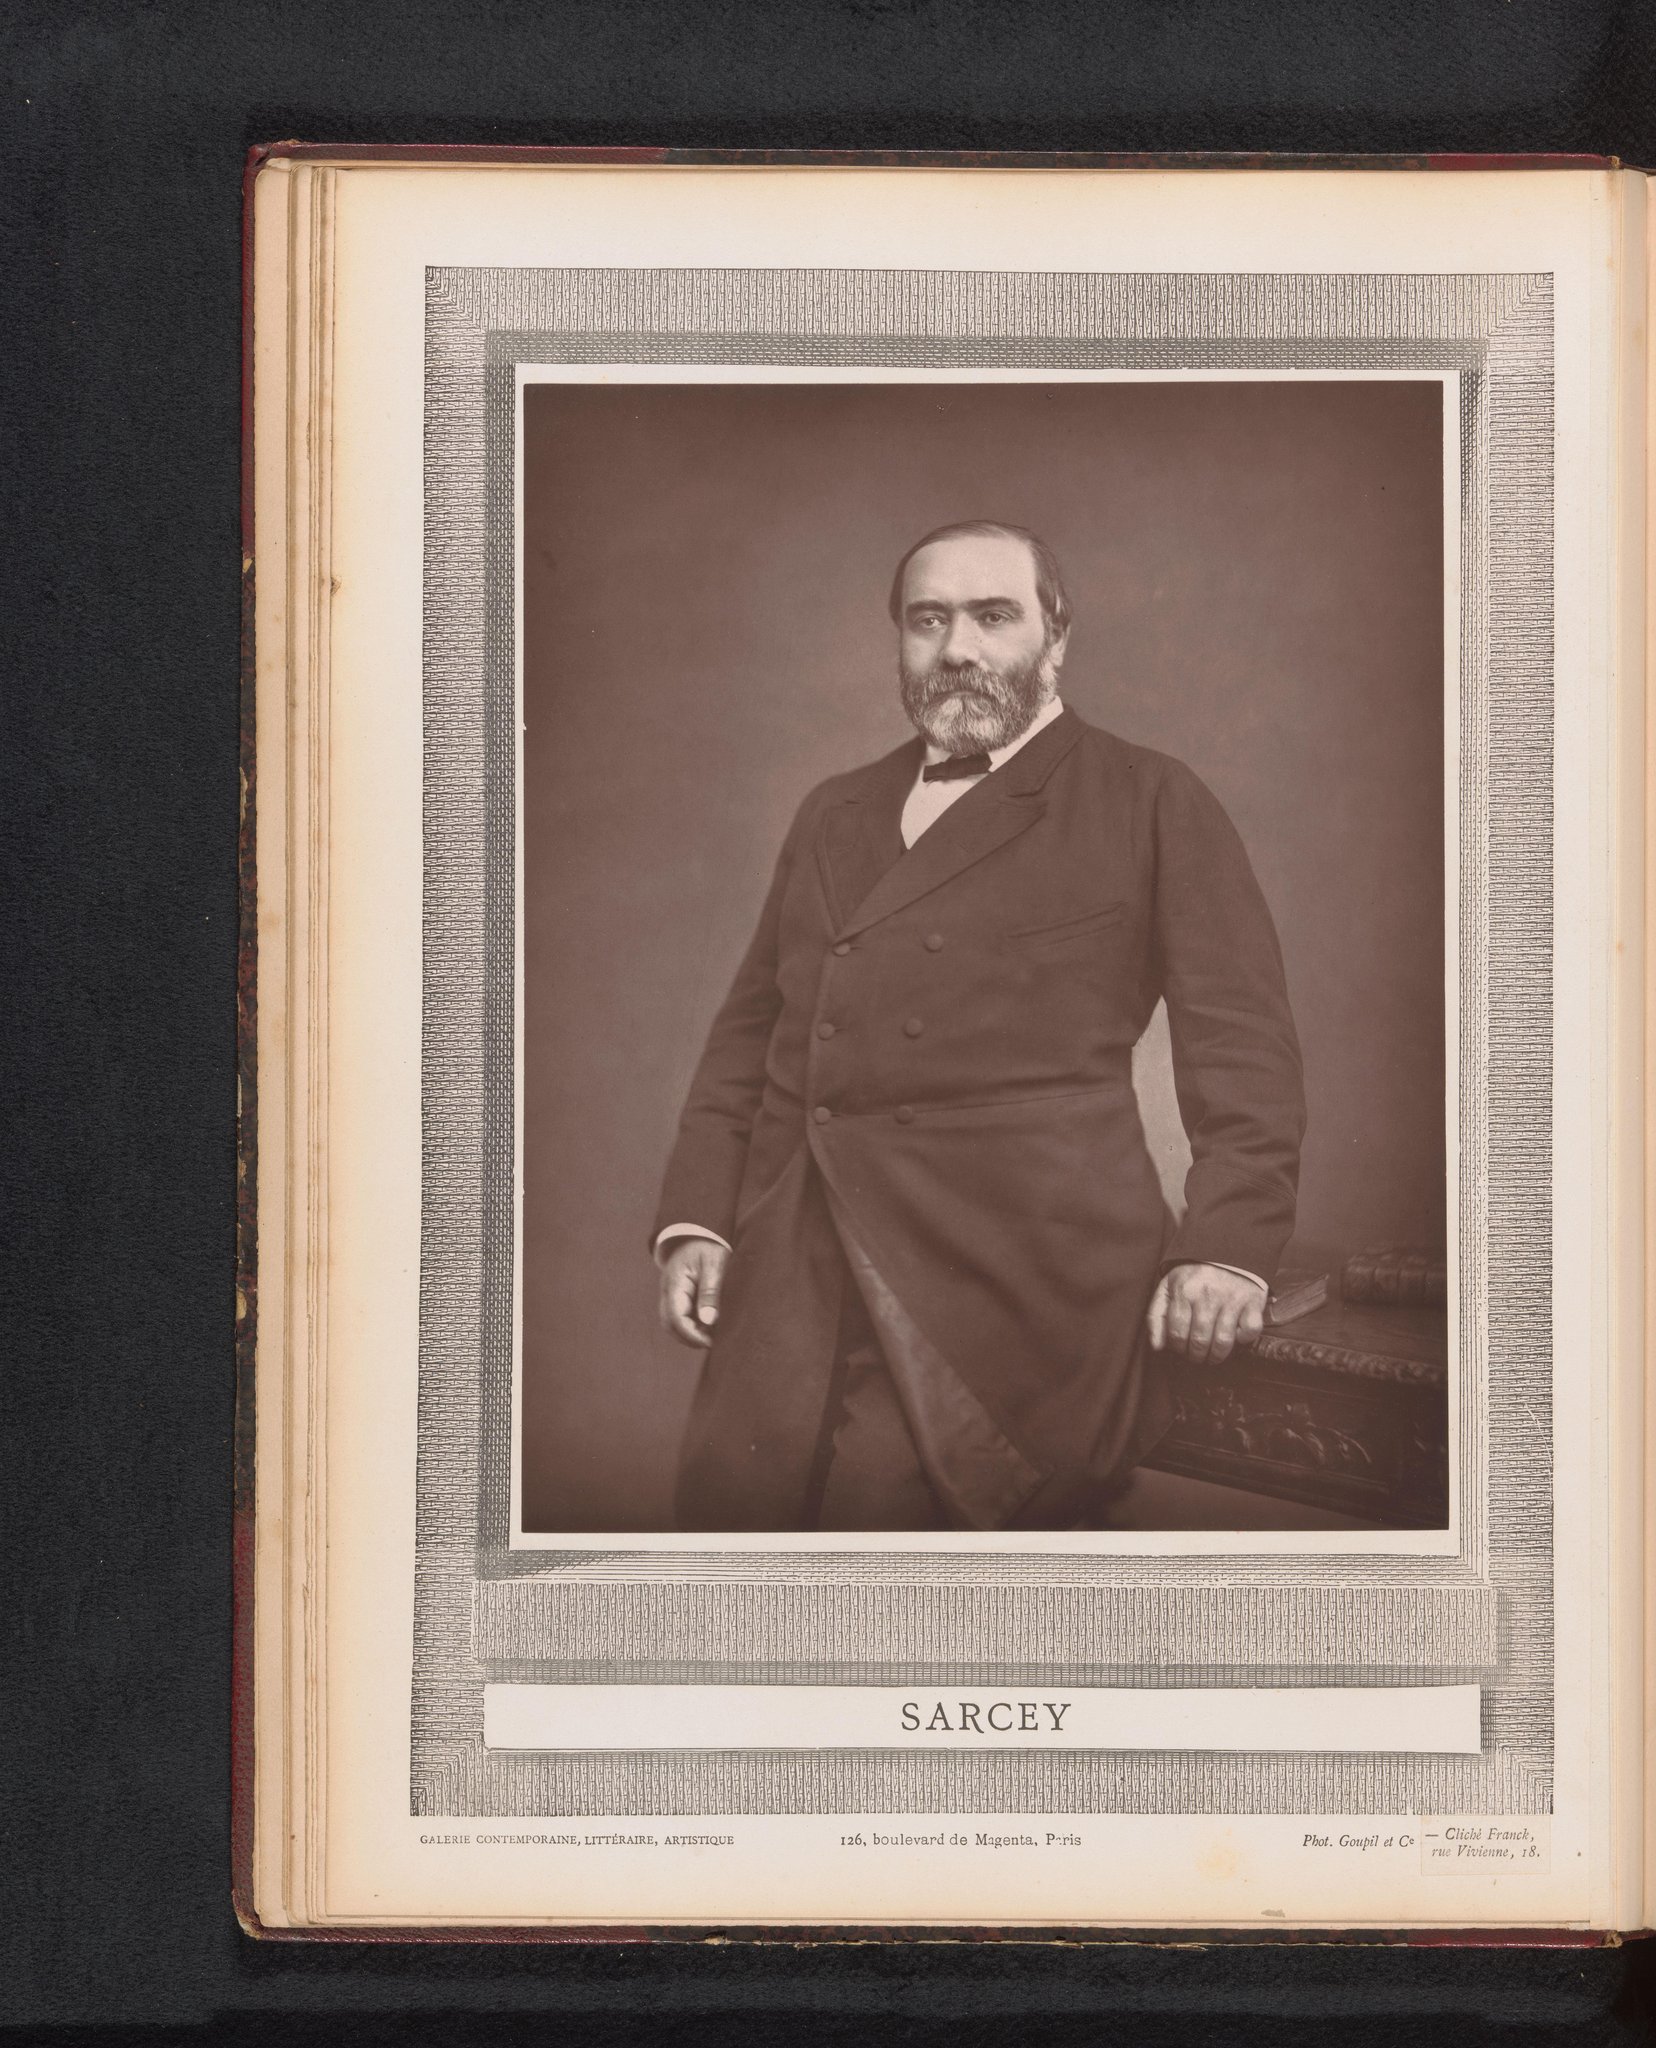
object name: page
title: Sarcey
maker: françois marie louis franck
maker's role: fotograaf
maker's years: 1816-1906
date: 1867-1877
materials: paper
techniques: woodburytype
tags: adult man, historical persons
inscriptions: inscription: ‘Galerie Contemporaine, Littéraire, Artistique/ 126, boulevard de Magenta, Paris’